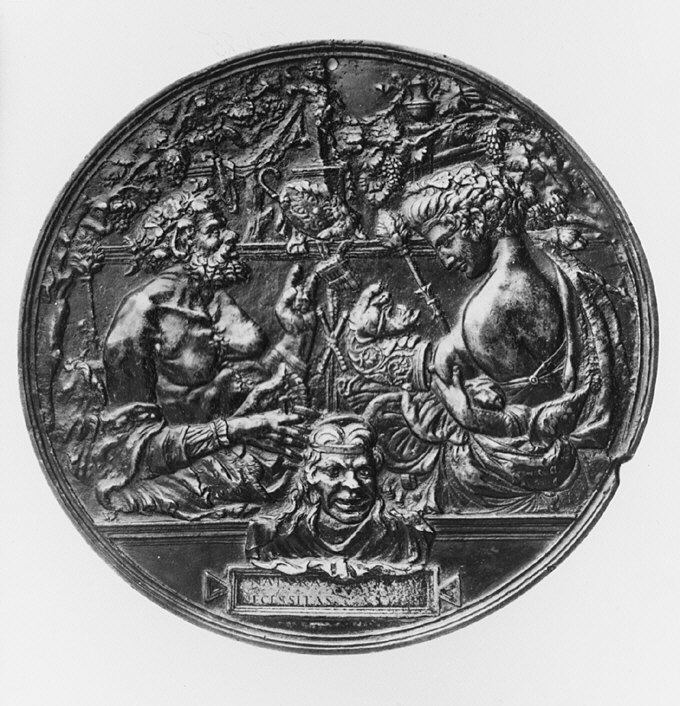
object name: plaque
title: Satyr and Bacchante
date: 1467-1500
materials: bronze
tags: men,bacchantes,satyrs